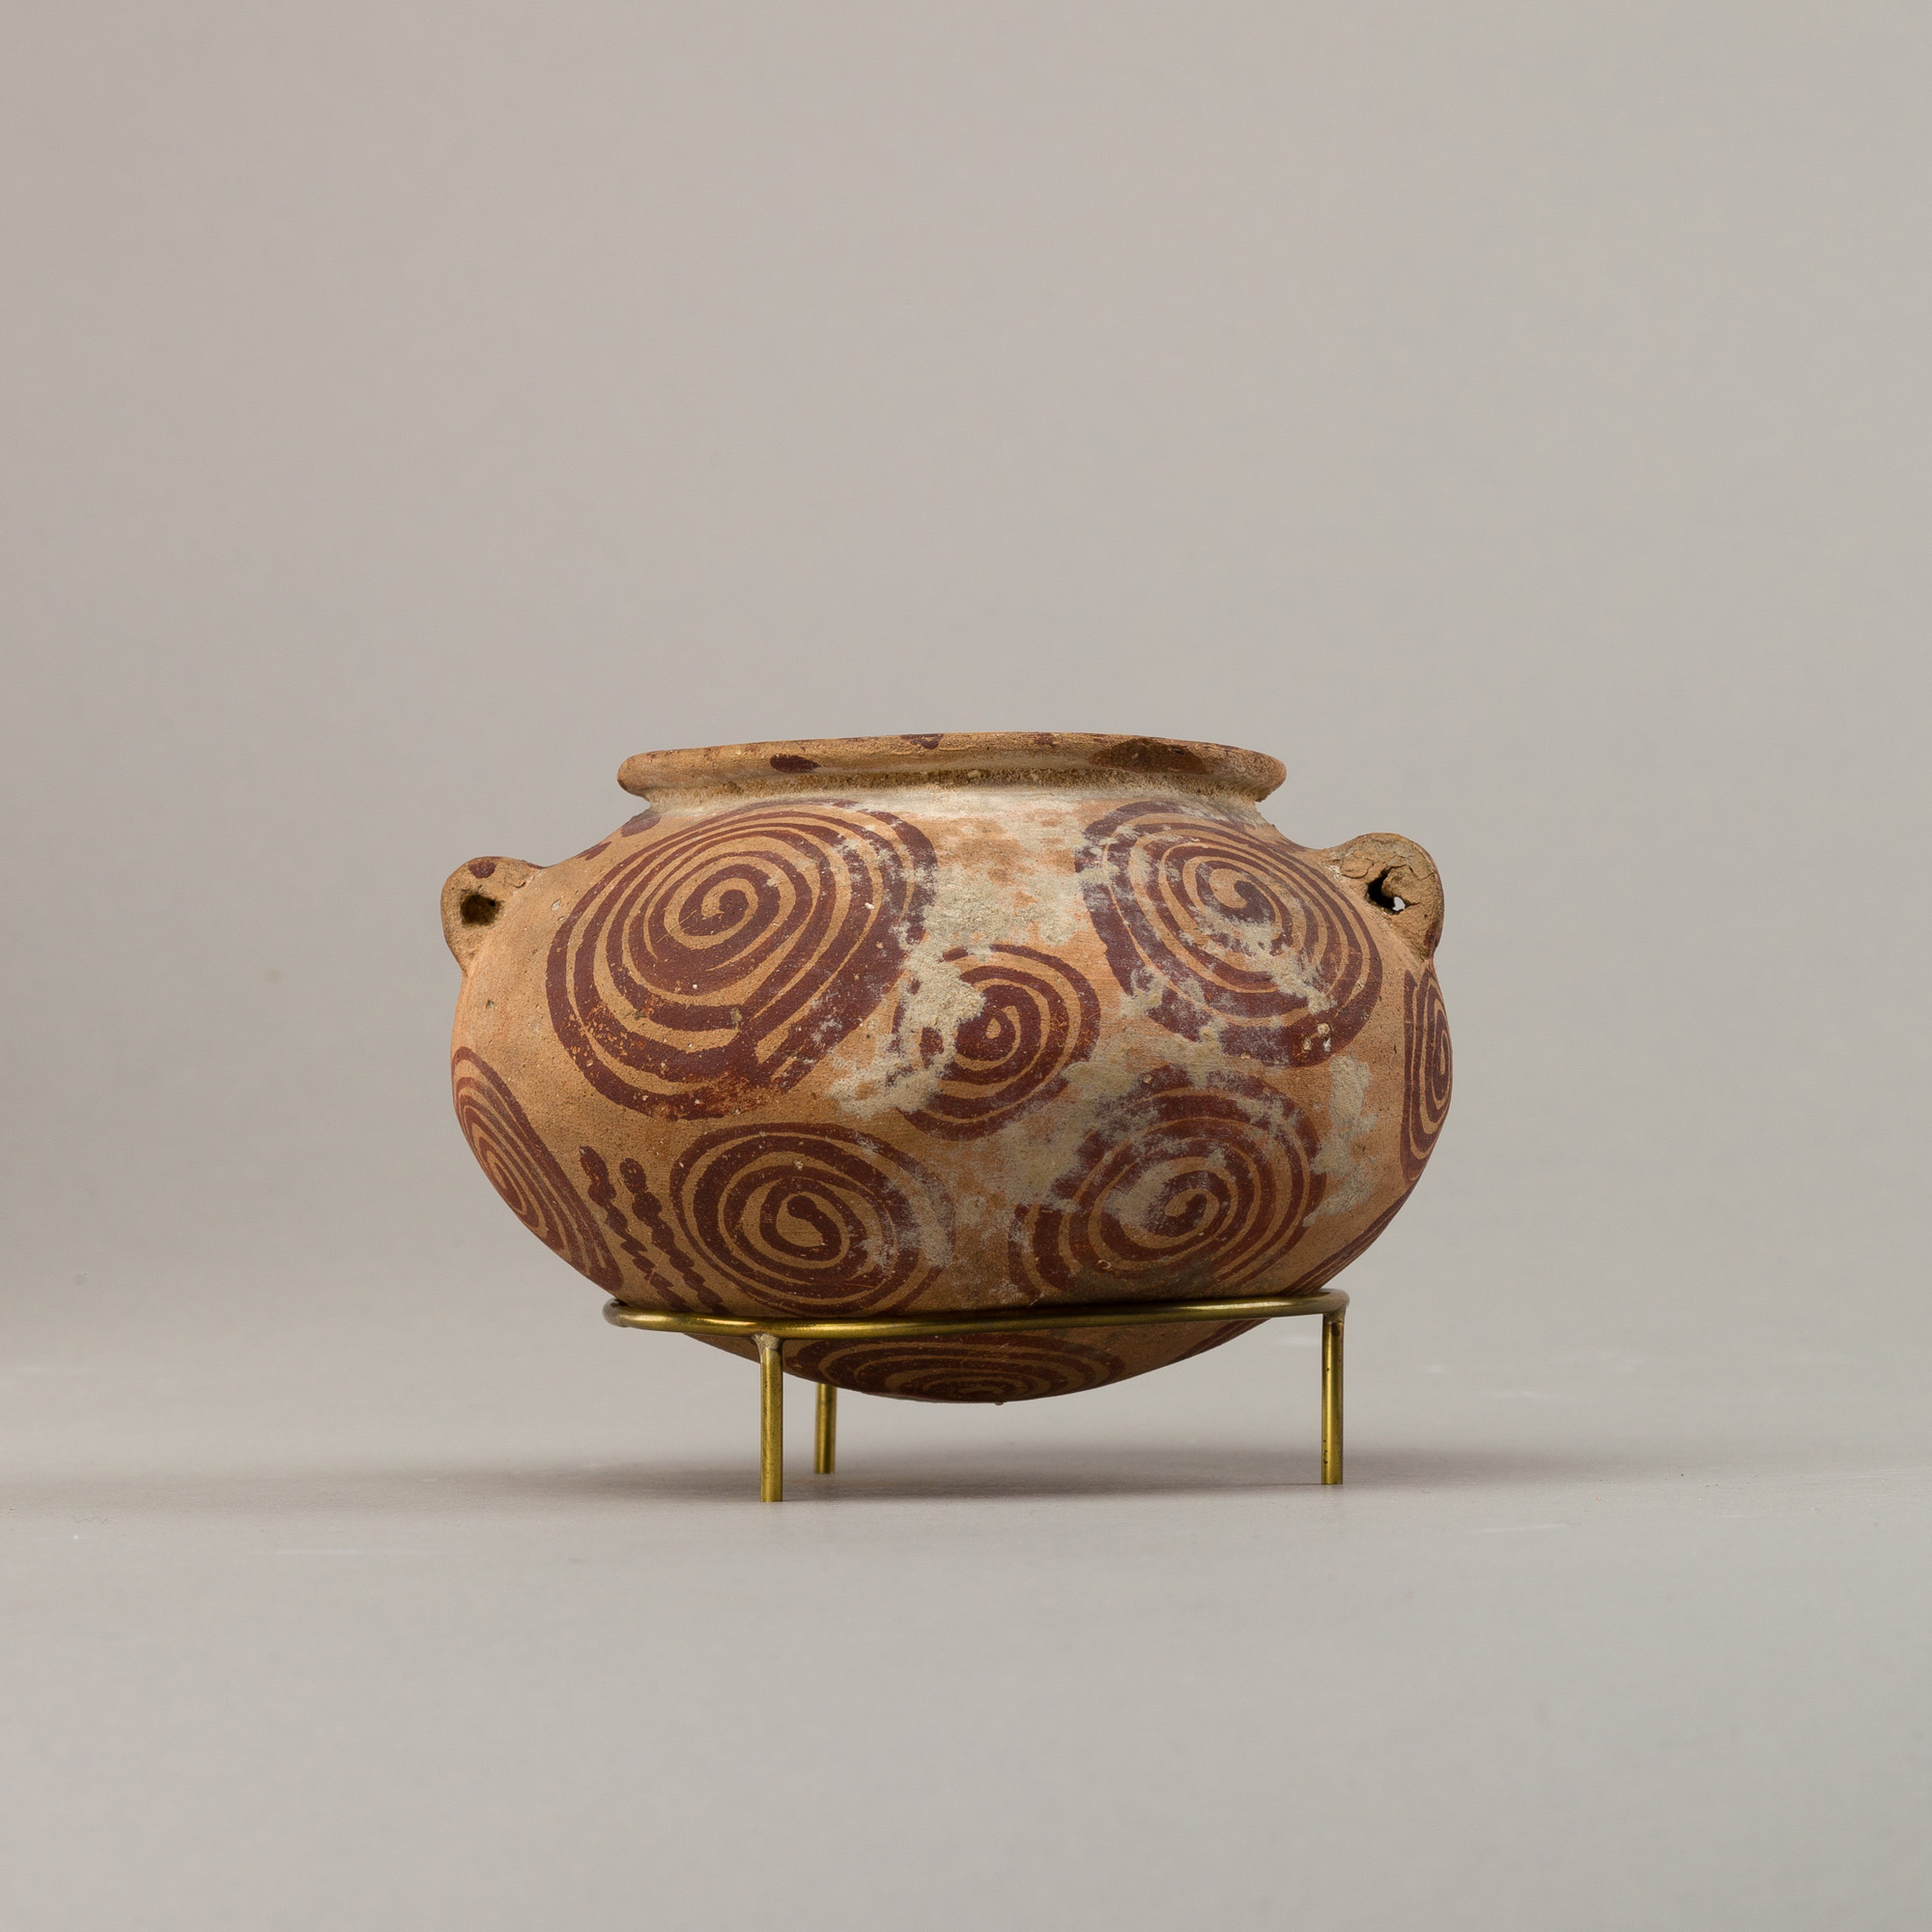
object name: jar, two handled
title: Decorated ware jar illustrating spirals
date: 3850-2960 BCE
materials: paint, pottery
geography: egypt